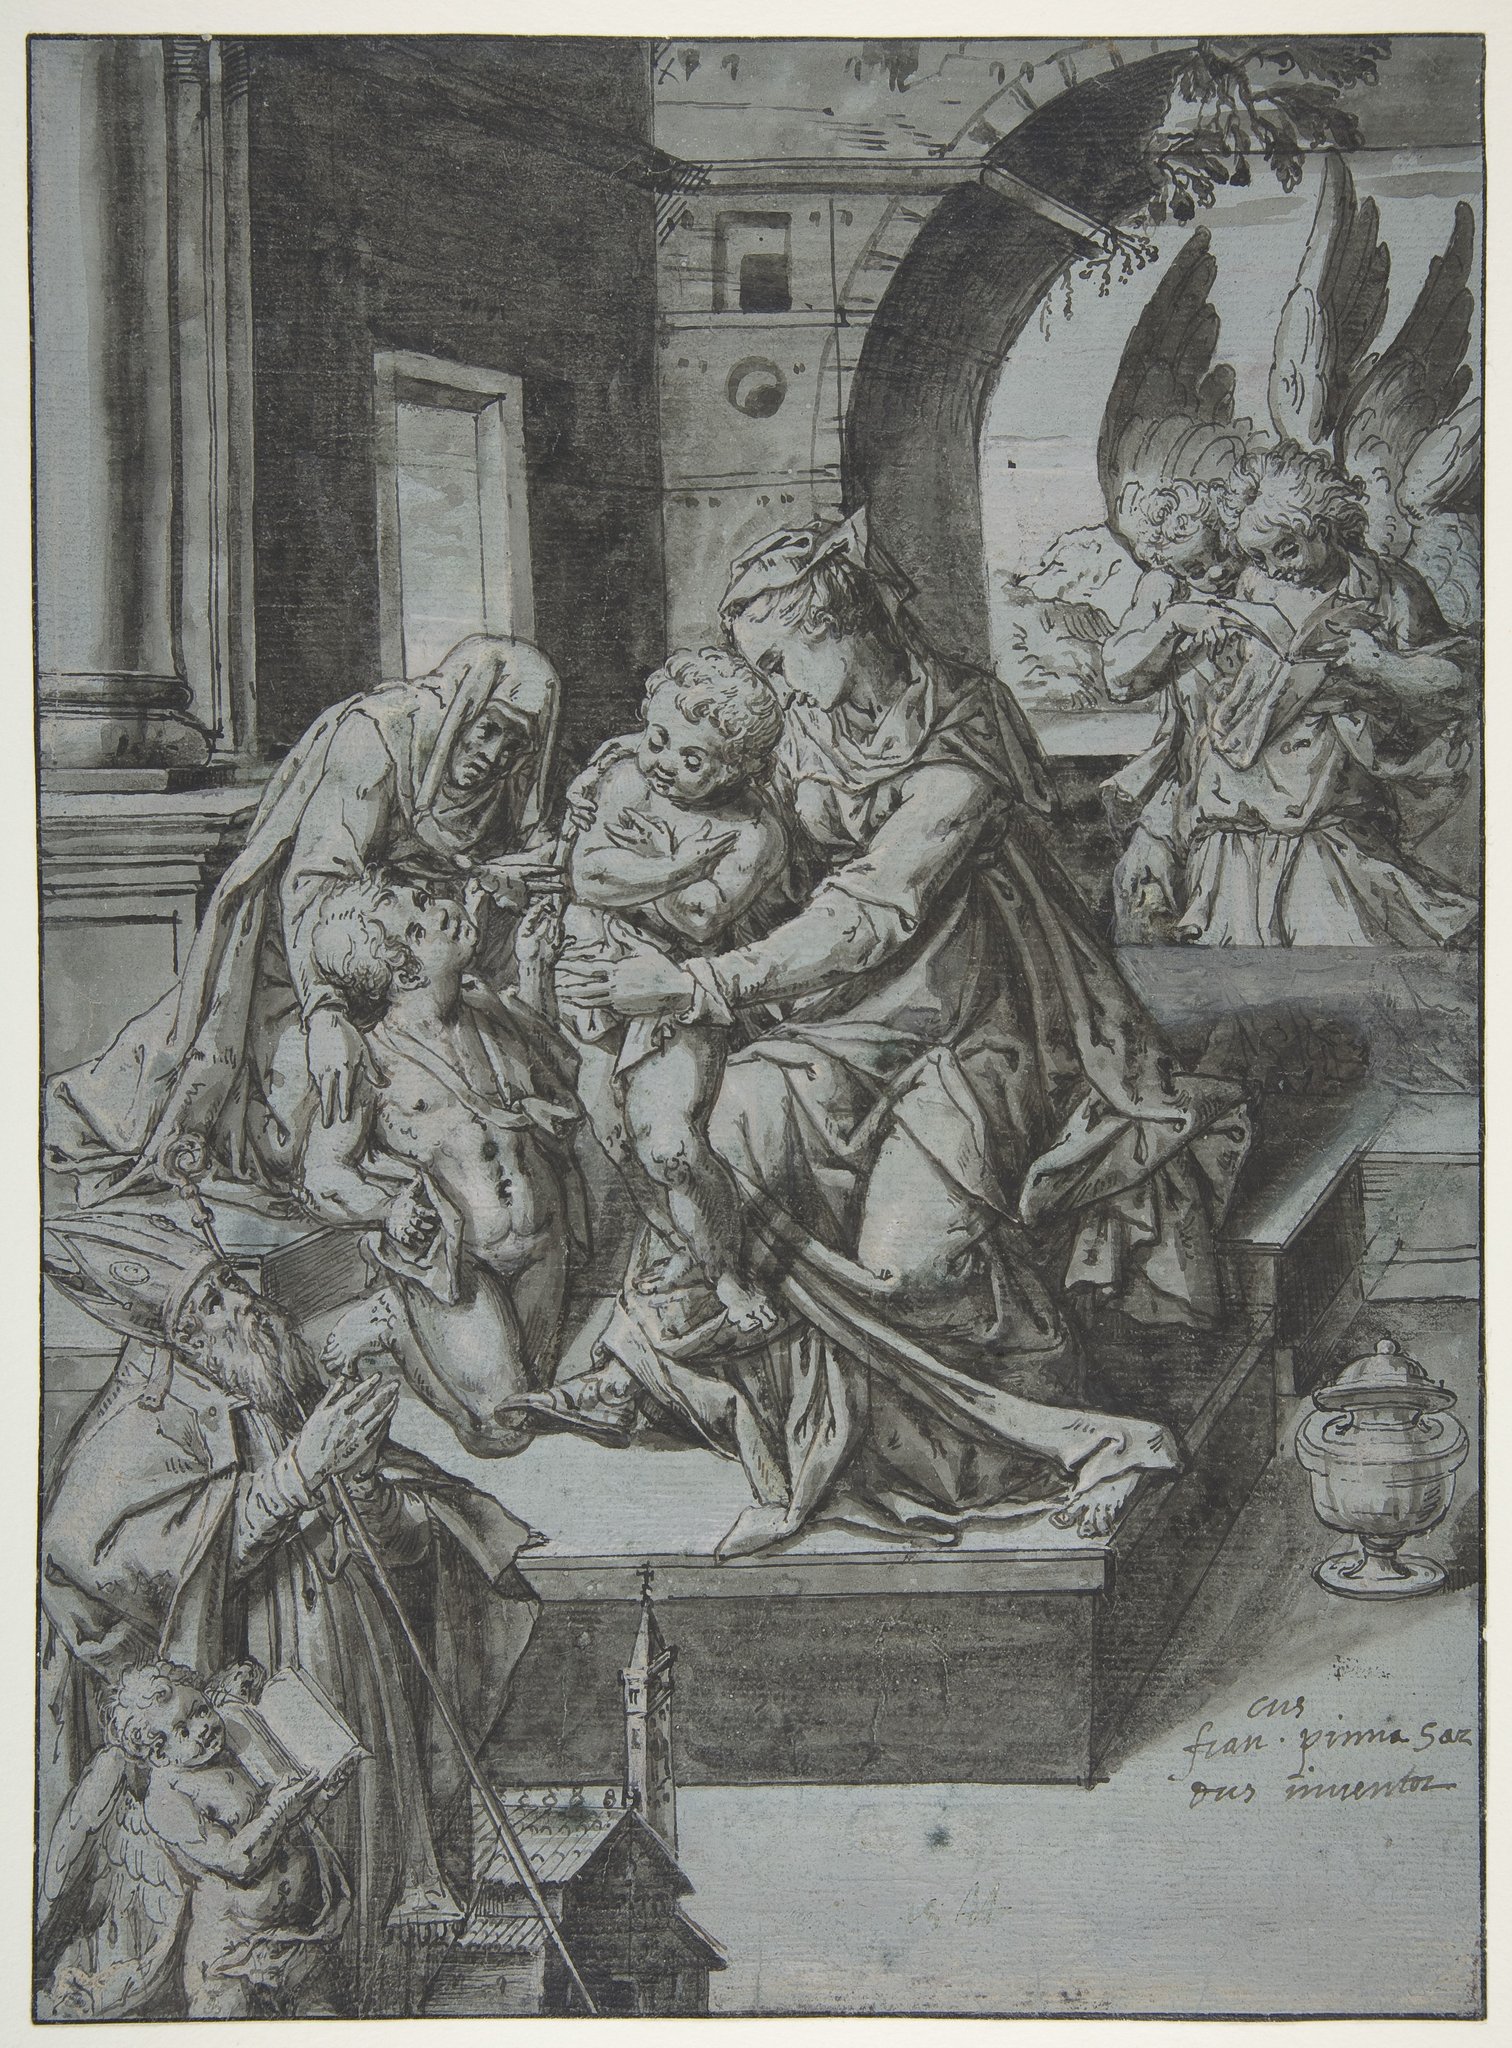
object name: drawing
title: The Virgin and Child with the Infant Baptist, Saint Elizabeth, a Kneeling Prelate, and Three Attendant Angels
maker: francesco pinna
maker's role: artist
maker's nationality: italian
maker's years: 1595-1632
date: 1595-1632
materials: ink, paper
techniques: brush, highlighting, pen, wash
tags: angels,holy family,madonna and child,saint john the baptist,saints